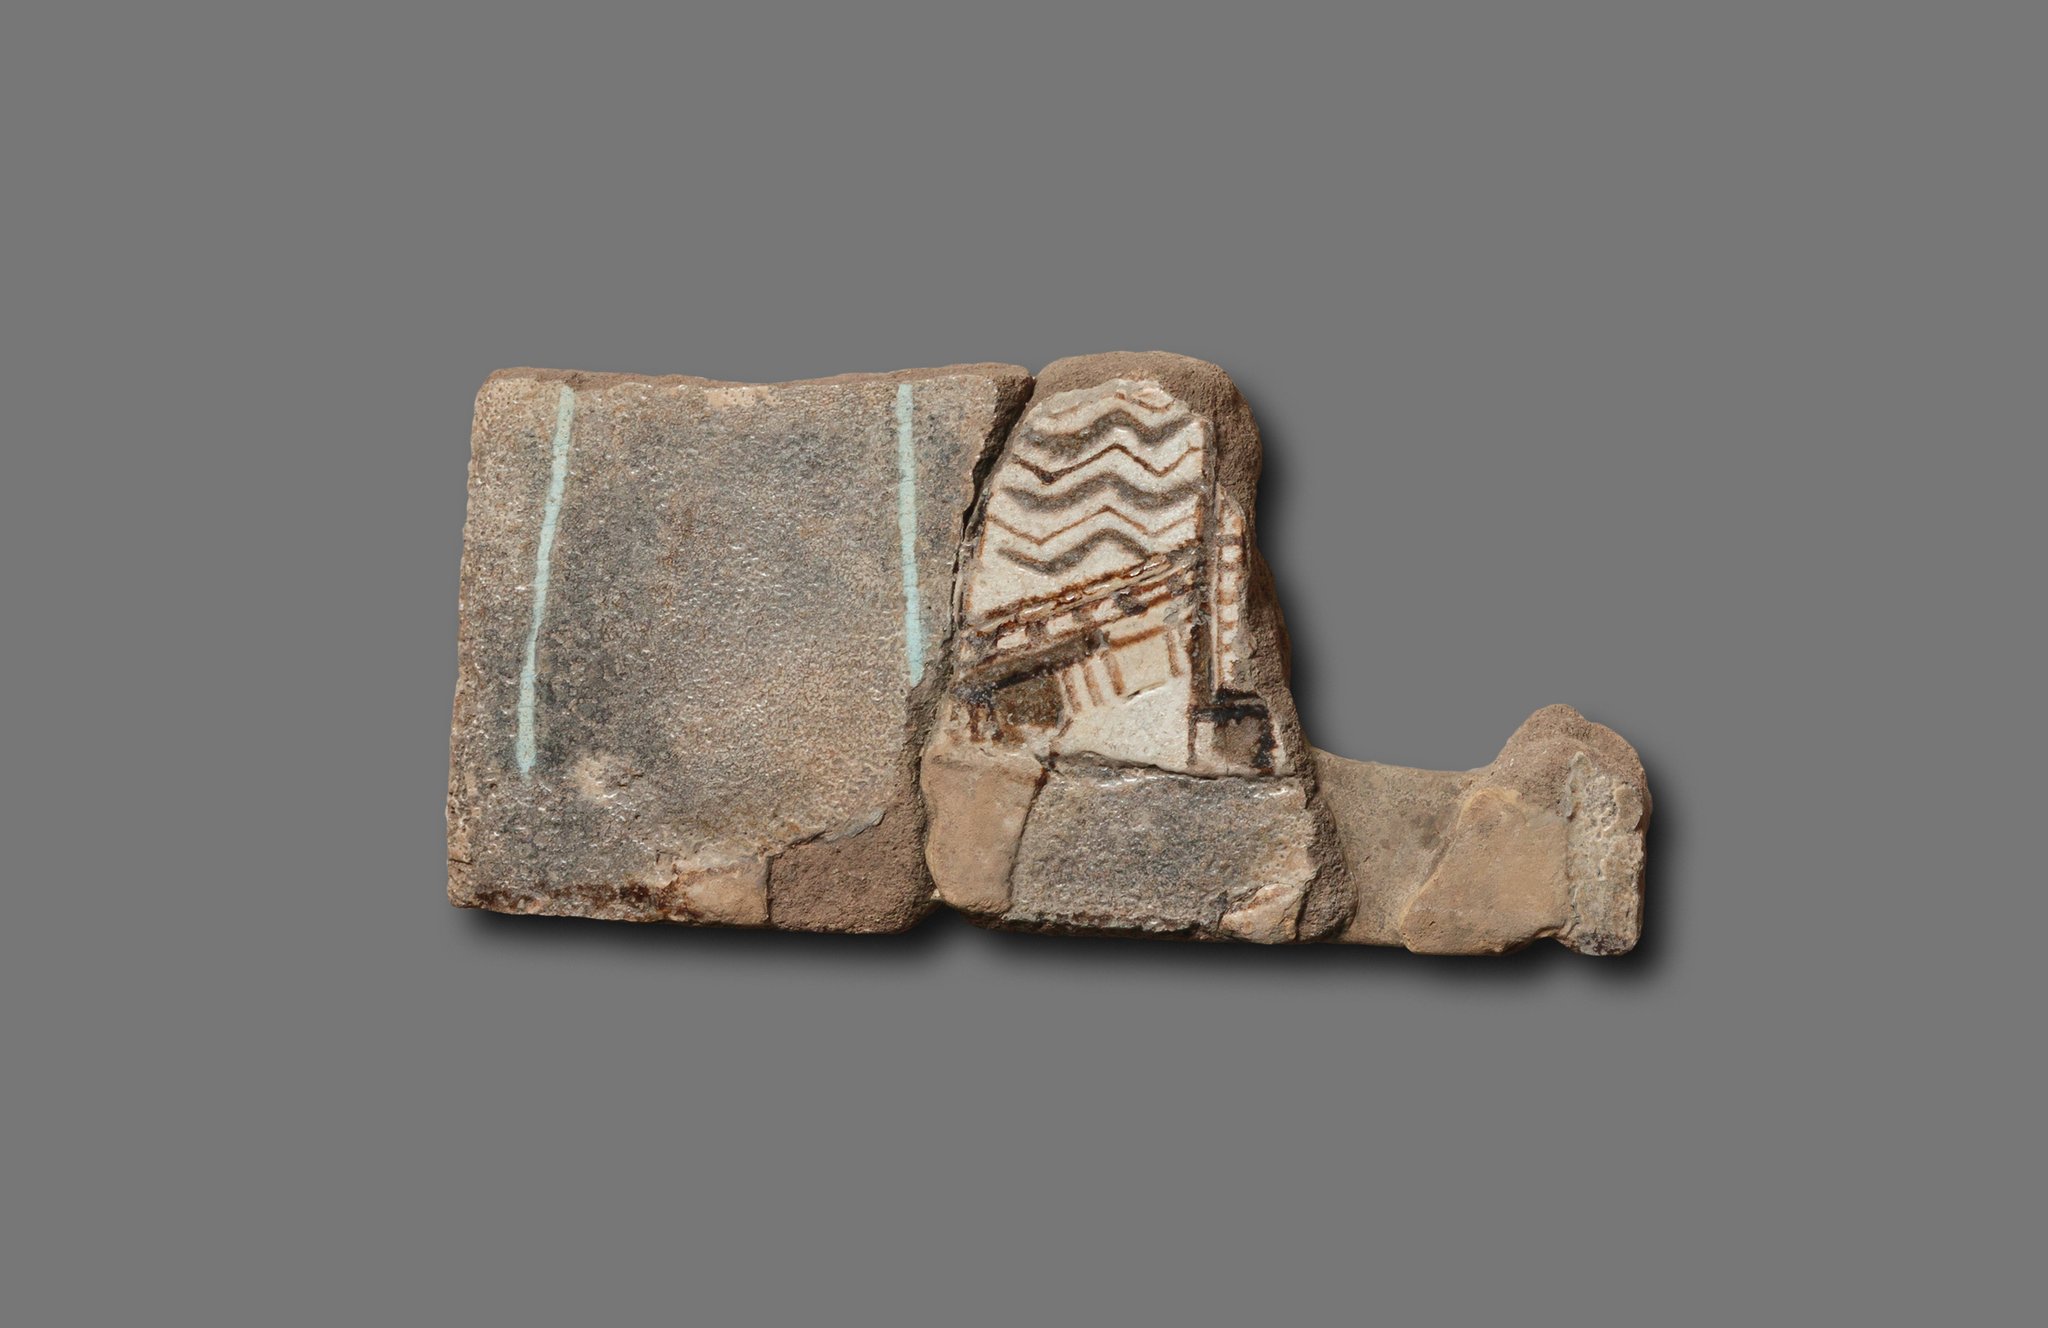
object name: tile inlay, palace of ramesses ii, foreigner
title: Tile from walls of Throne Room in the palace of Ramesses II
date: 1279-1213 BCE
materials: faience, paste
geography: egypt